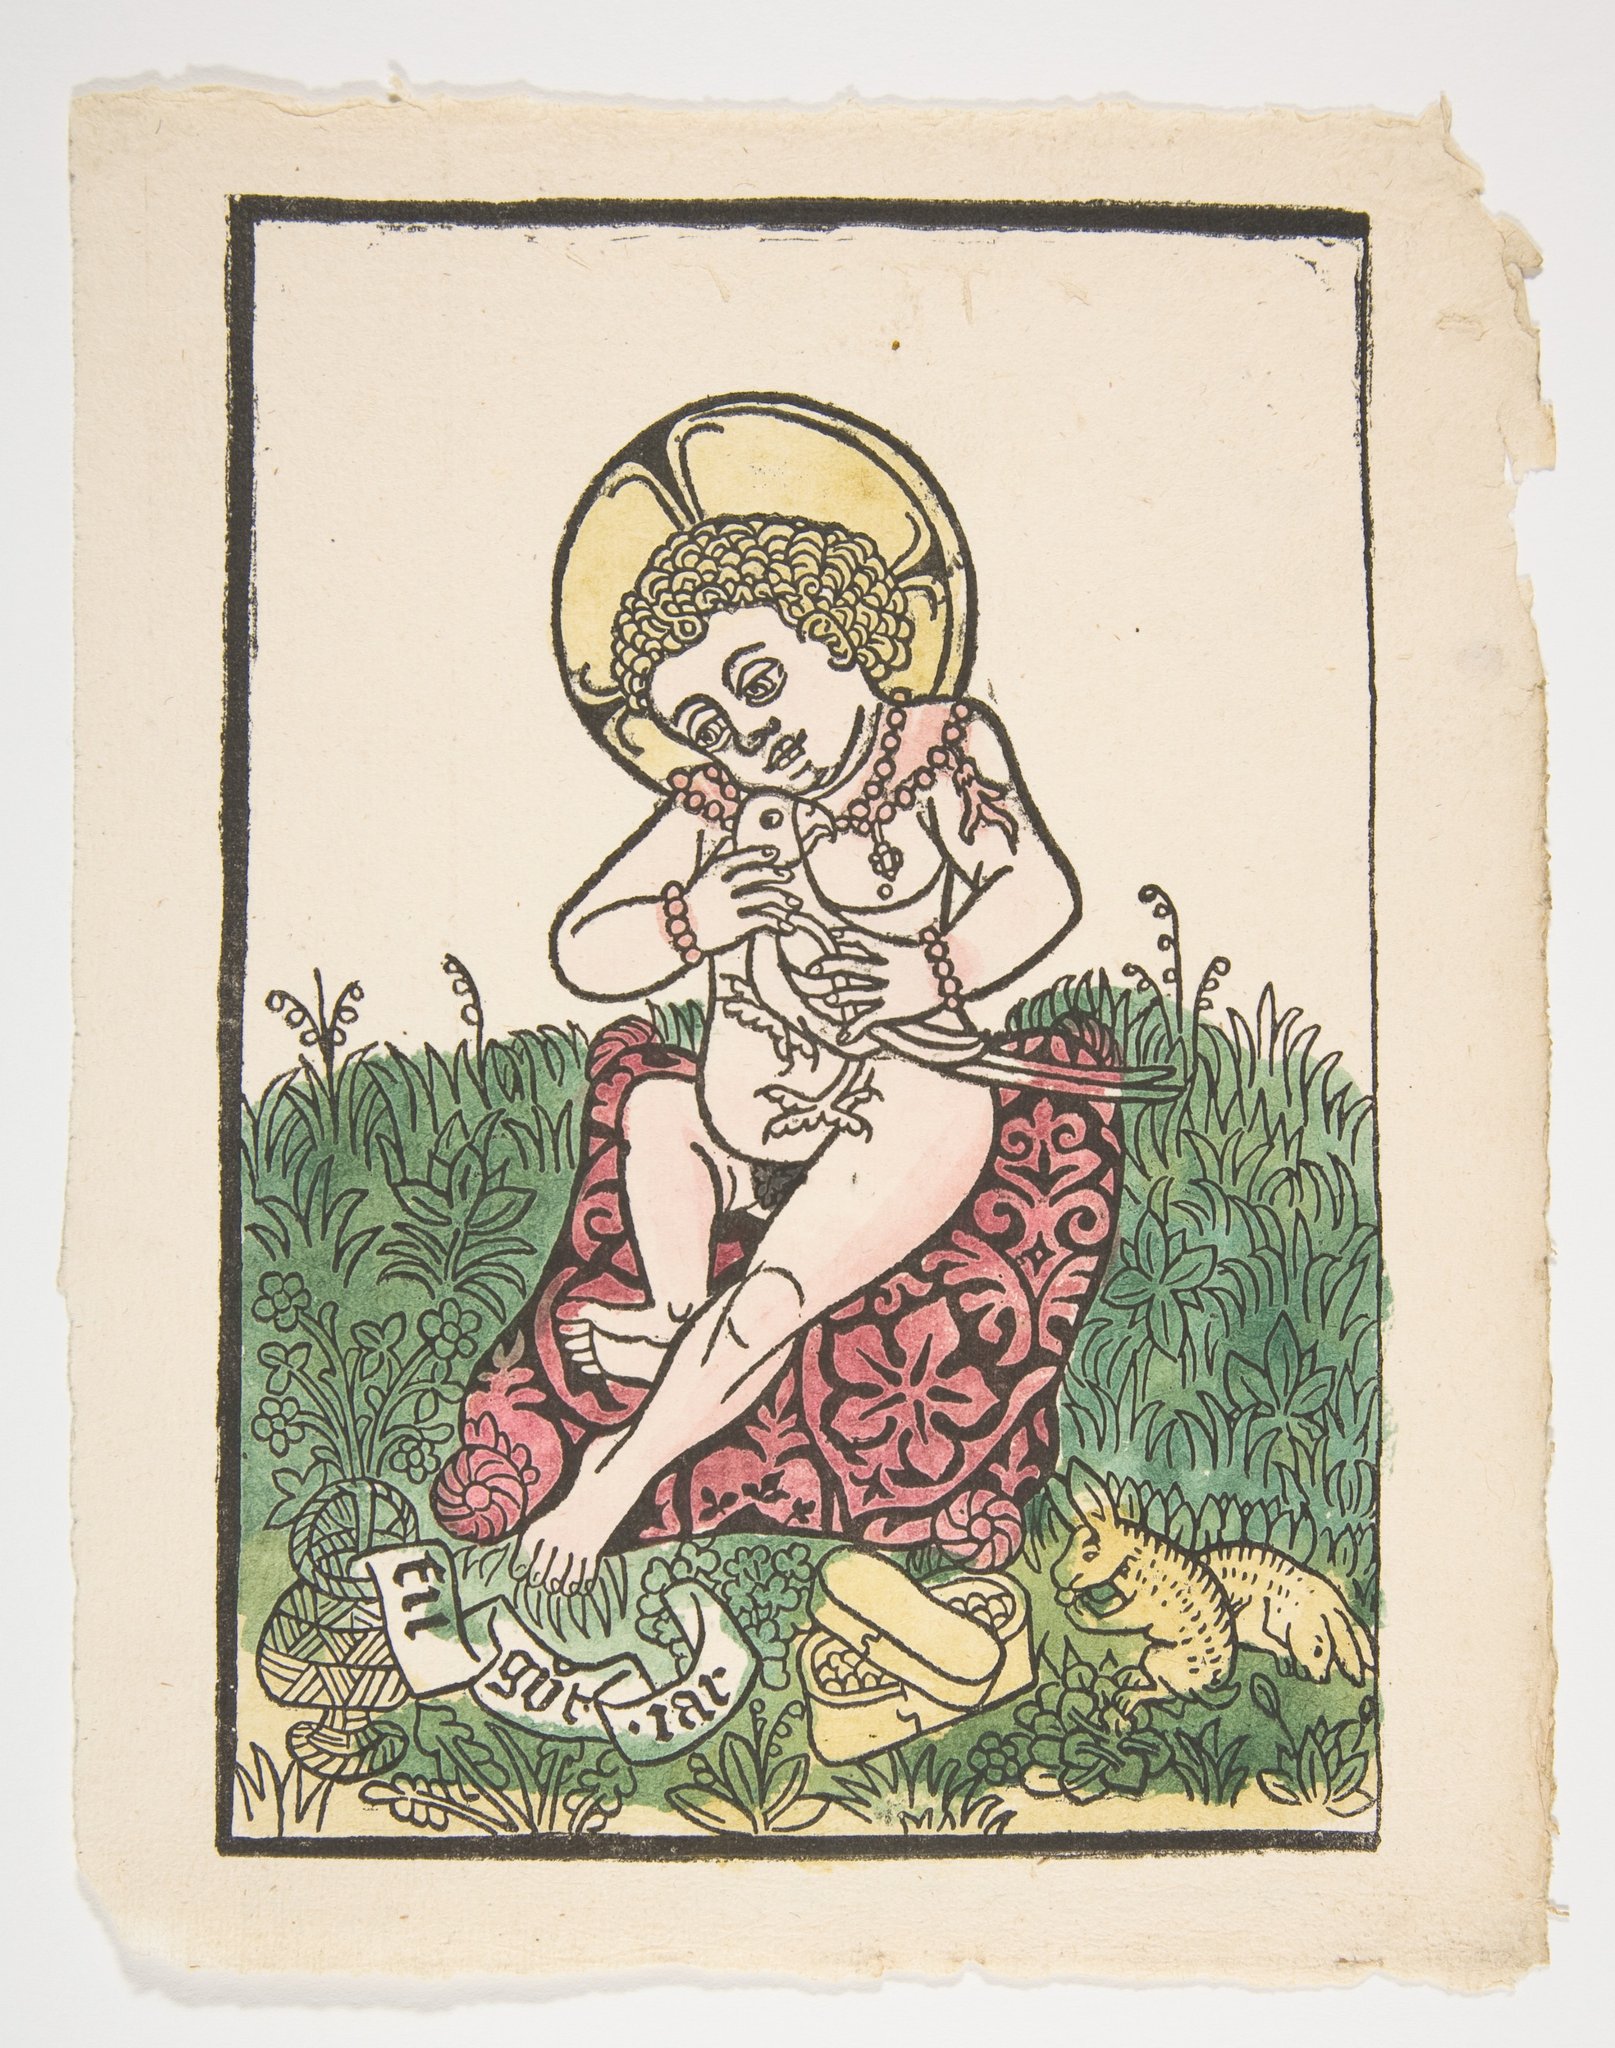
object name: print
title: Christ Child With New Year's Wish (Schr. 784)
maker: anonymous, german, 15th century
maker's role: artist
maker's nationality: german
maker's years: 1400-1500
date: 1401-1500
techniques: hand coloring, woodcut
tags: parrots,rabbits,christ